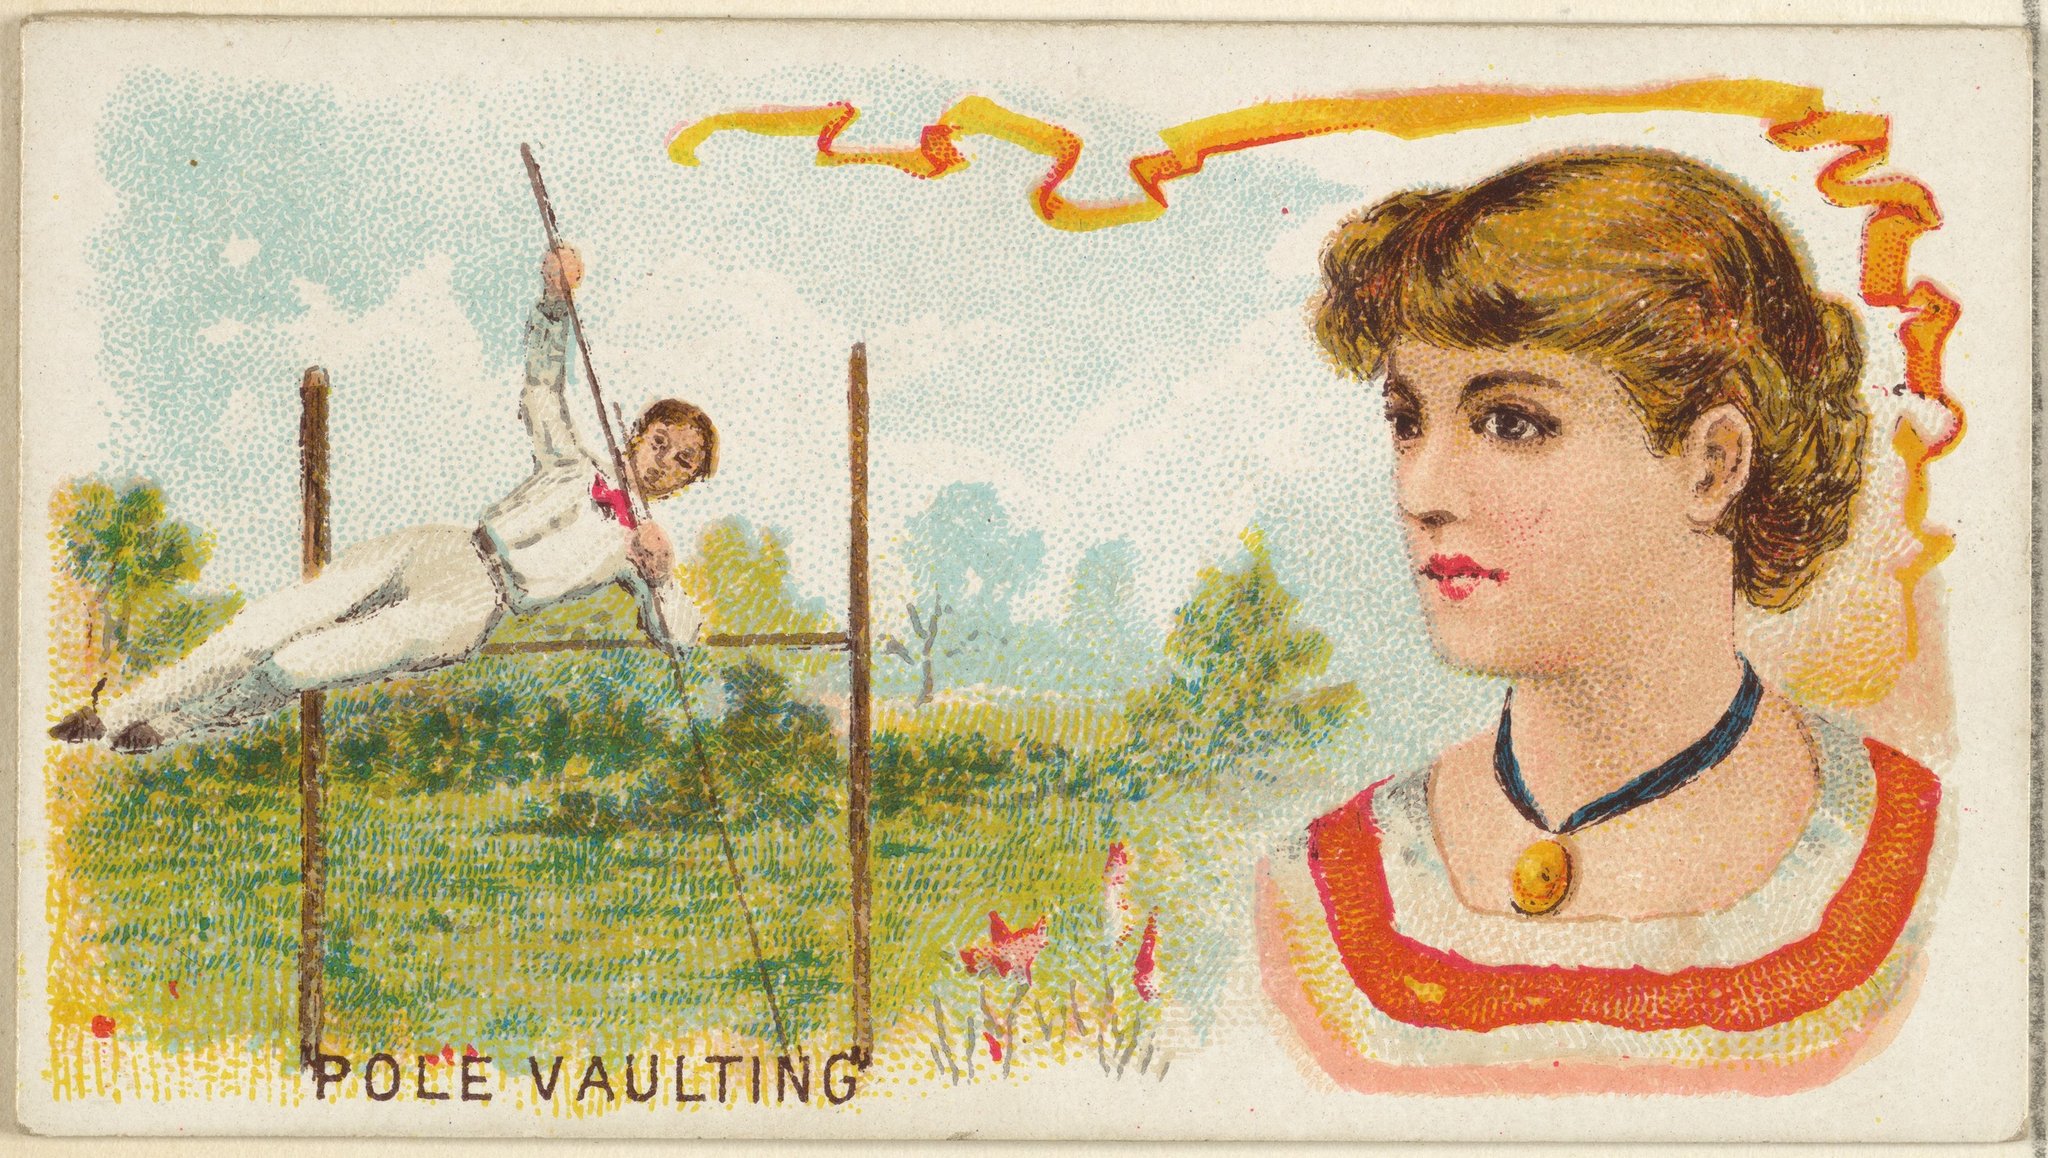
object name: print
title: Pole Vaulting, from the Games and Sports series (N165) for Old Judge Cigarettes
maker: goodwin & company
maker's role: publisher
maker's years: 1850-1950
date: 1889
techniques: color lithograph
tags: women,sports,athletes